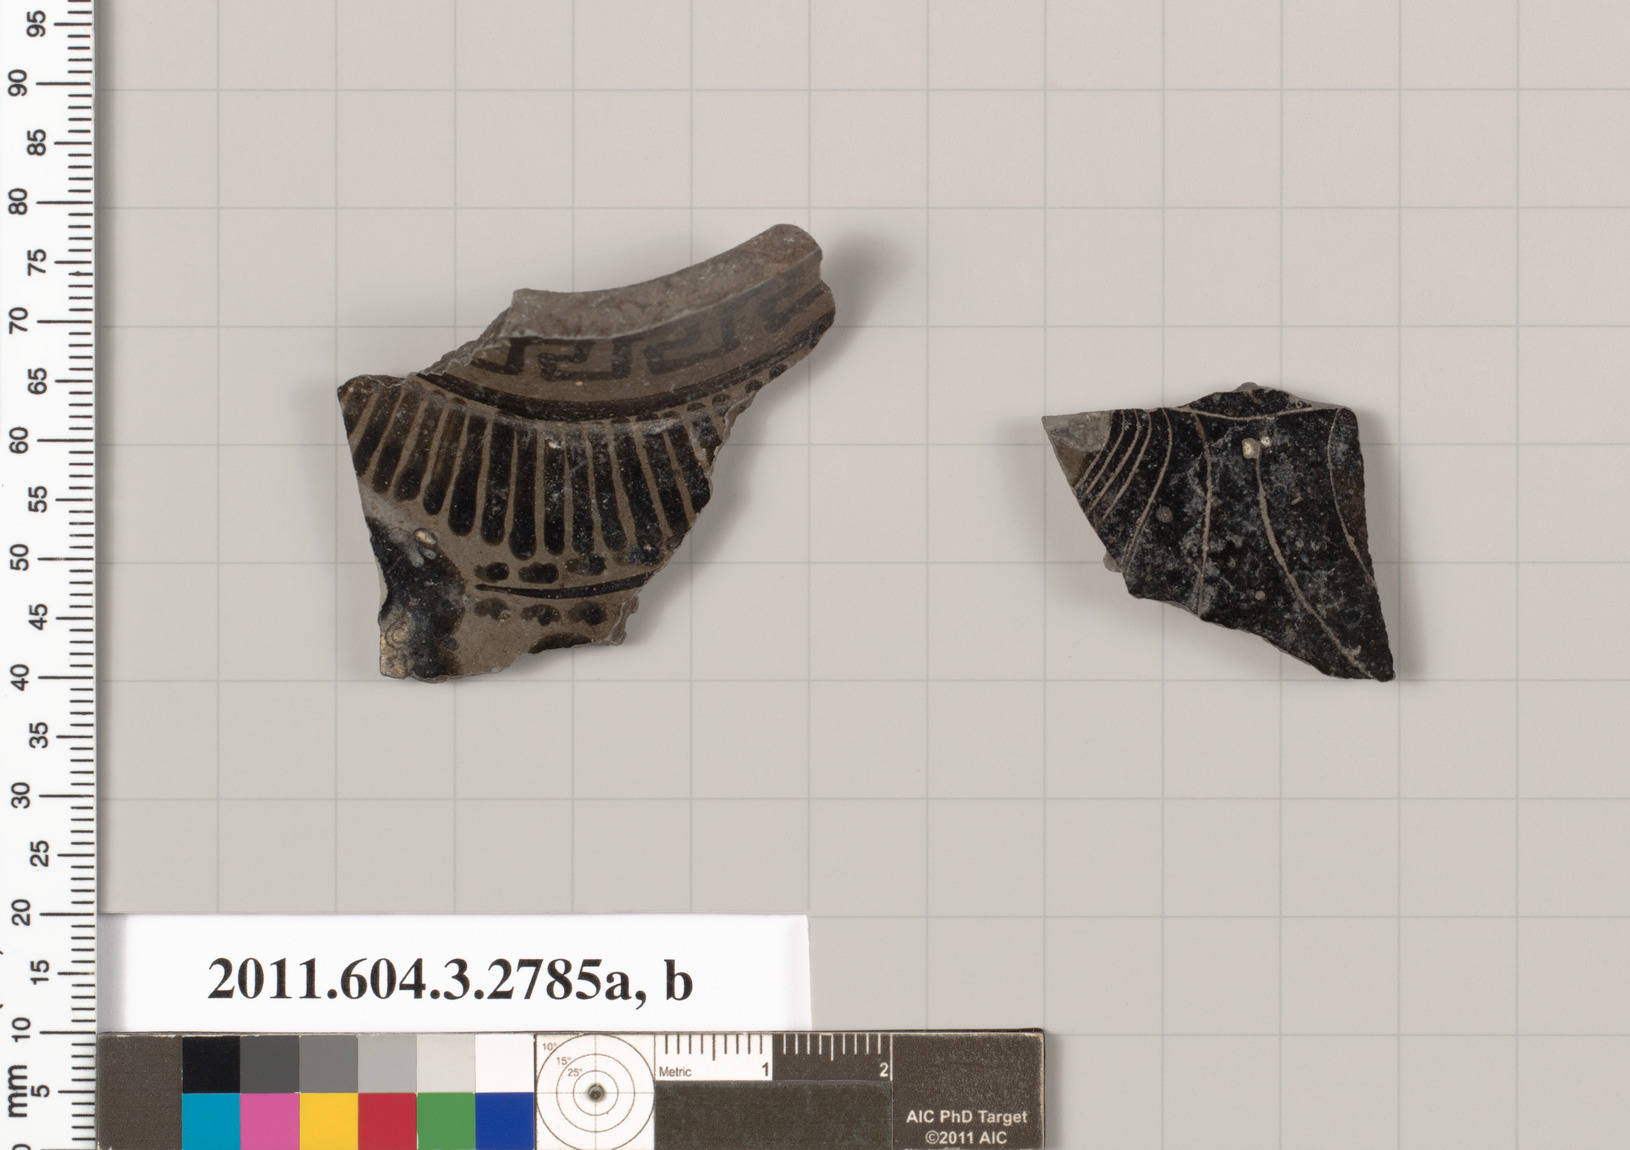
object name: oinochoe fragment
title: Terracotta fragments of an oinochoe (jug)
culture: greek, attic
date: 525-501 BCE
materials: terracotta